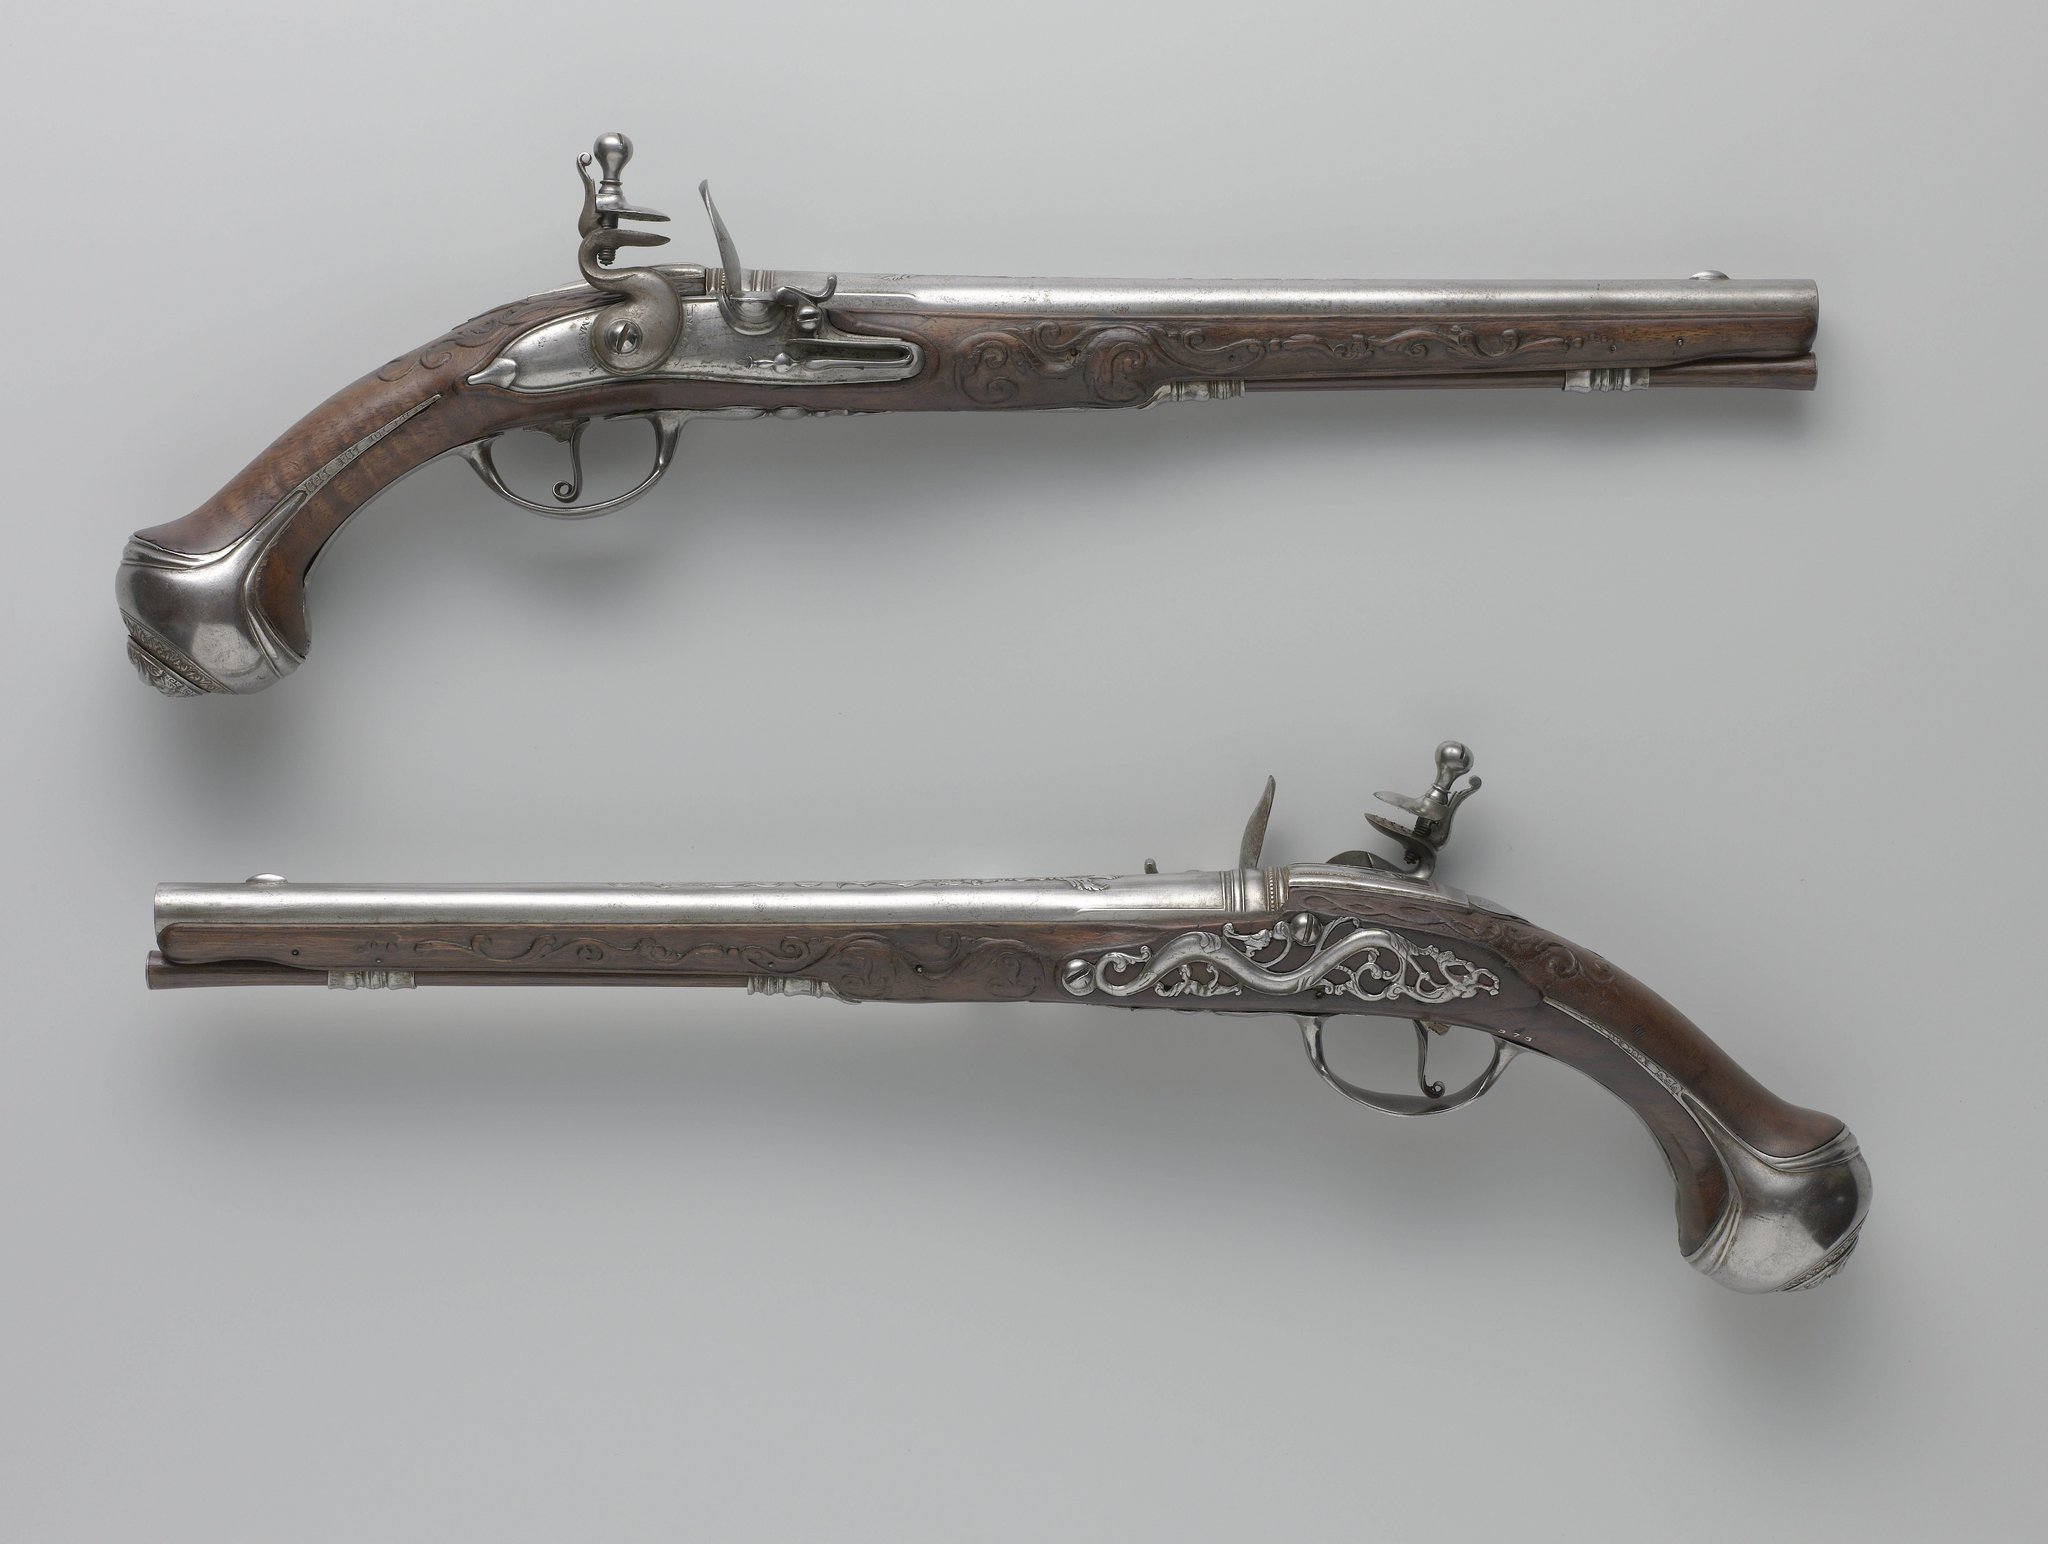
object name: flintlock pistol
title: Vuursteenpistool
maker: j. depré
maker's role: geweermaker, pistoolmaker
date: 1700-1715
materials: iron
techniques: printing, cutting, embroidery, engraving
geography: maastricht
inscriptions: coat of arms, : ‘N 39’, signature: ‘J.DEPRE aMASTRECH’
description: Deel van een koppel. Het slot is nagenoeg onversierd; gesigneerd. De loop is in reliëf gebeiteld met vertakt lofwerk en een draak, voorzien van een ijzeren korrel en onderop gestempeld met het wapen van Maastricht. De kolf is gesneden met onder meer bladerranken. Het ijzeren beslag bestaat onder andere uit een schroefplaat in de vorm van een zeeslang, maar zonder hoofd en voorzien van ajour bewerkte bladerranken, de staart van de loop met versiering in de vorm van een ui met de inscriptie N 39, en de kolfdekplaat gebeiteld met een masker met acanthusbladeren eromheen.